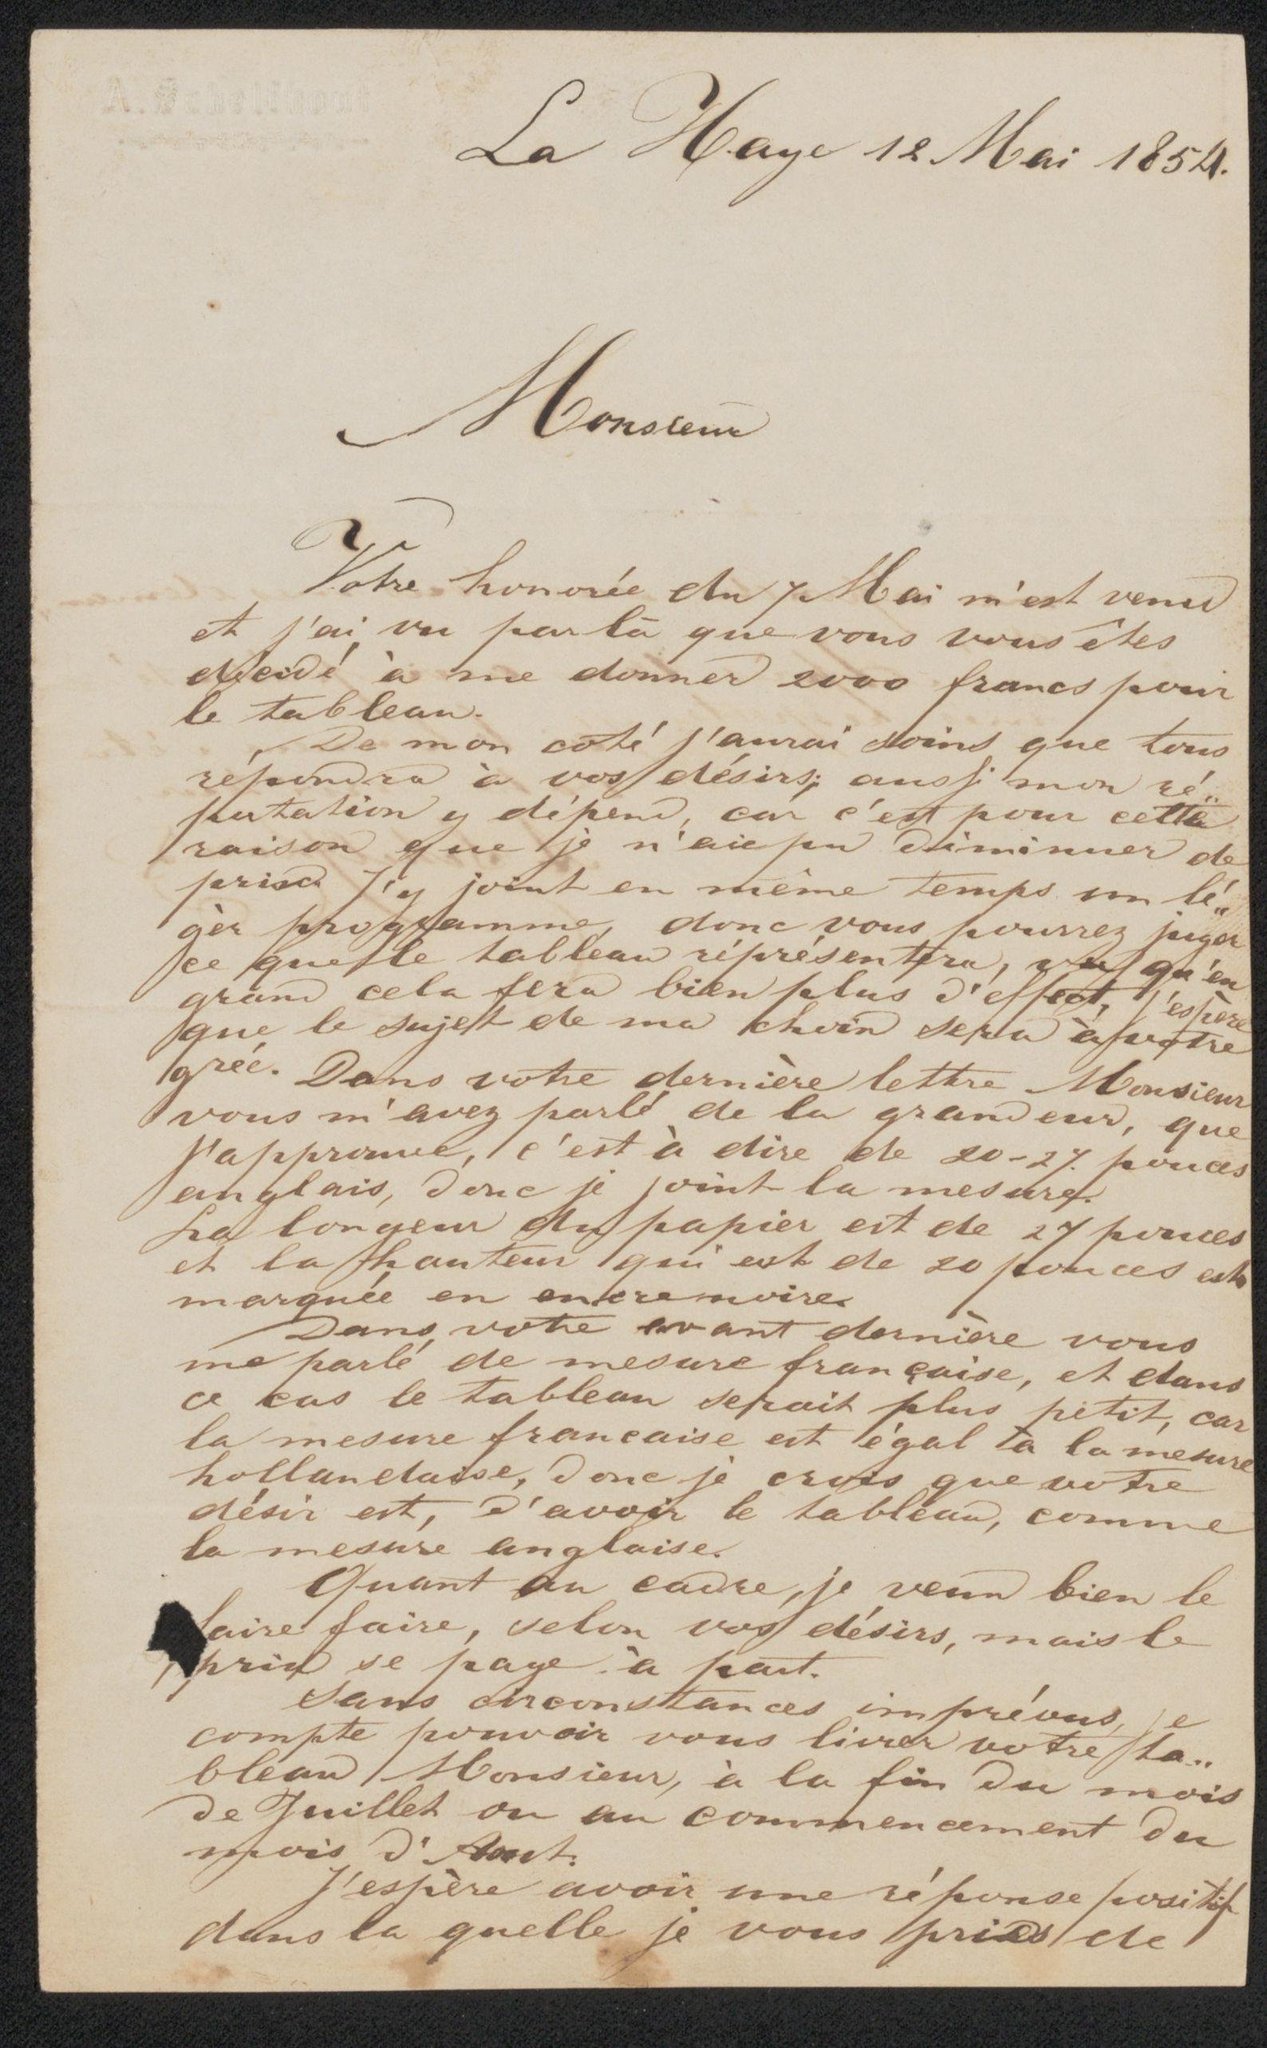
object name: letter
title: Brief aan anoniem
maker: andreas schelfhout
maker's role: draughtsman, painter, print maker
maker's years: 1787-1870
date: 1854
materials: ink, paper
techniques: pen, writing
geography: the hague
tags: painting (including book-illumination, miniature-painting), money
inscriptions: collector's mark: ‘RPK’, name: ‘A.Schelfhout’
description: Schets RP-D-1982-41B is samen met de brief verstuurd.